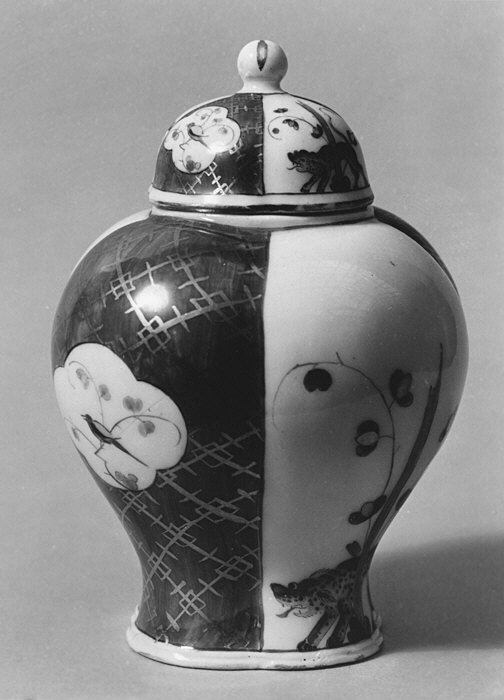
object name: caddy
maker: meissen manufactory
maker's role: manufactory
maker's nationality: german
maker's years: 1710-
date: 1735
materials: hard paste porcelain